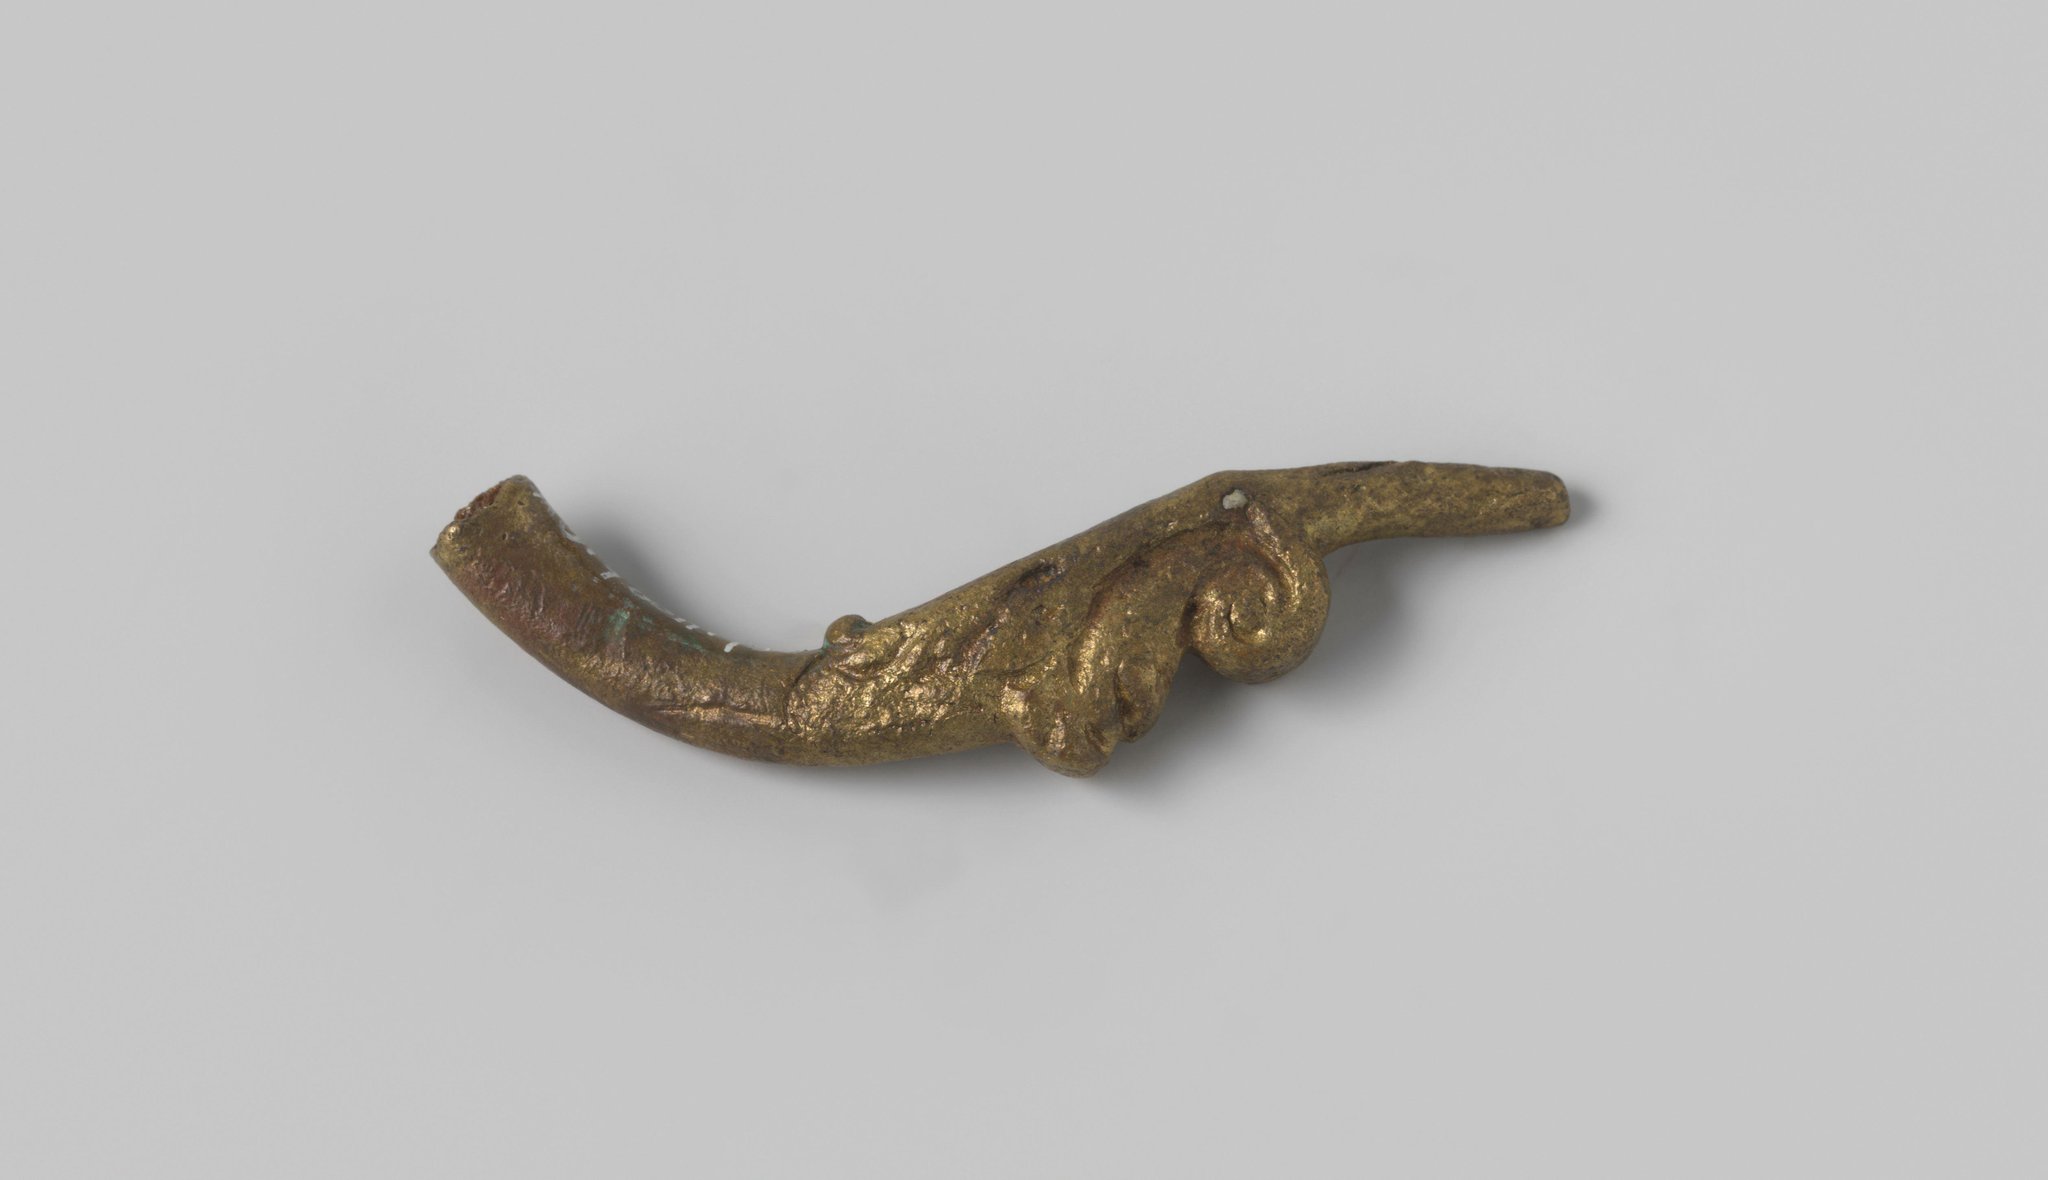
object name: beugel gevestl, gevestbeugel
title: Fragment beugel van gevest uit het wrak van de Oost-Indiëvaarder Hollandia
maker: Anonymous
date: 1700-1743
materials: copper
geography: netherlands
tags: verenigde oostindische compagnie, hollandia (schip), annet